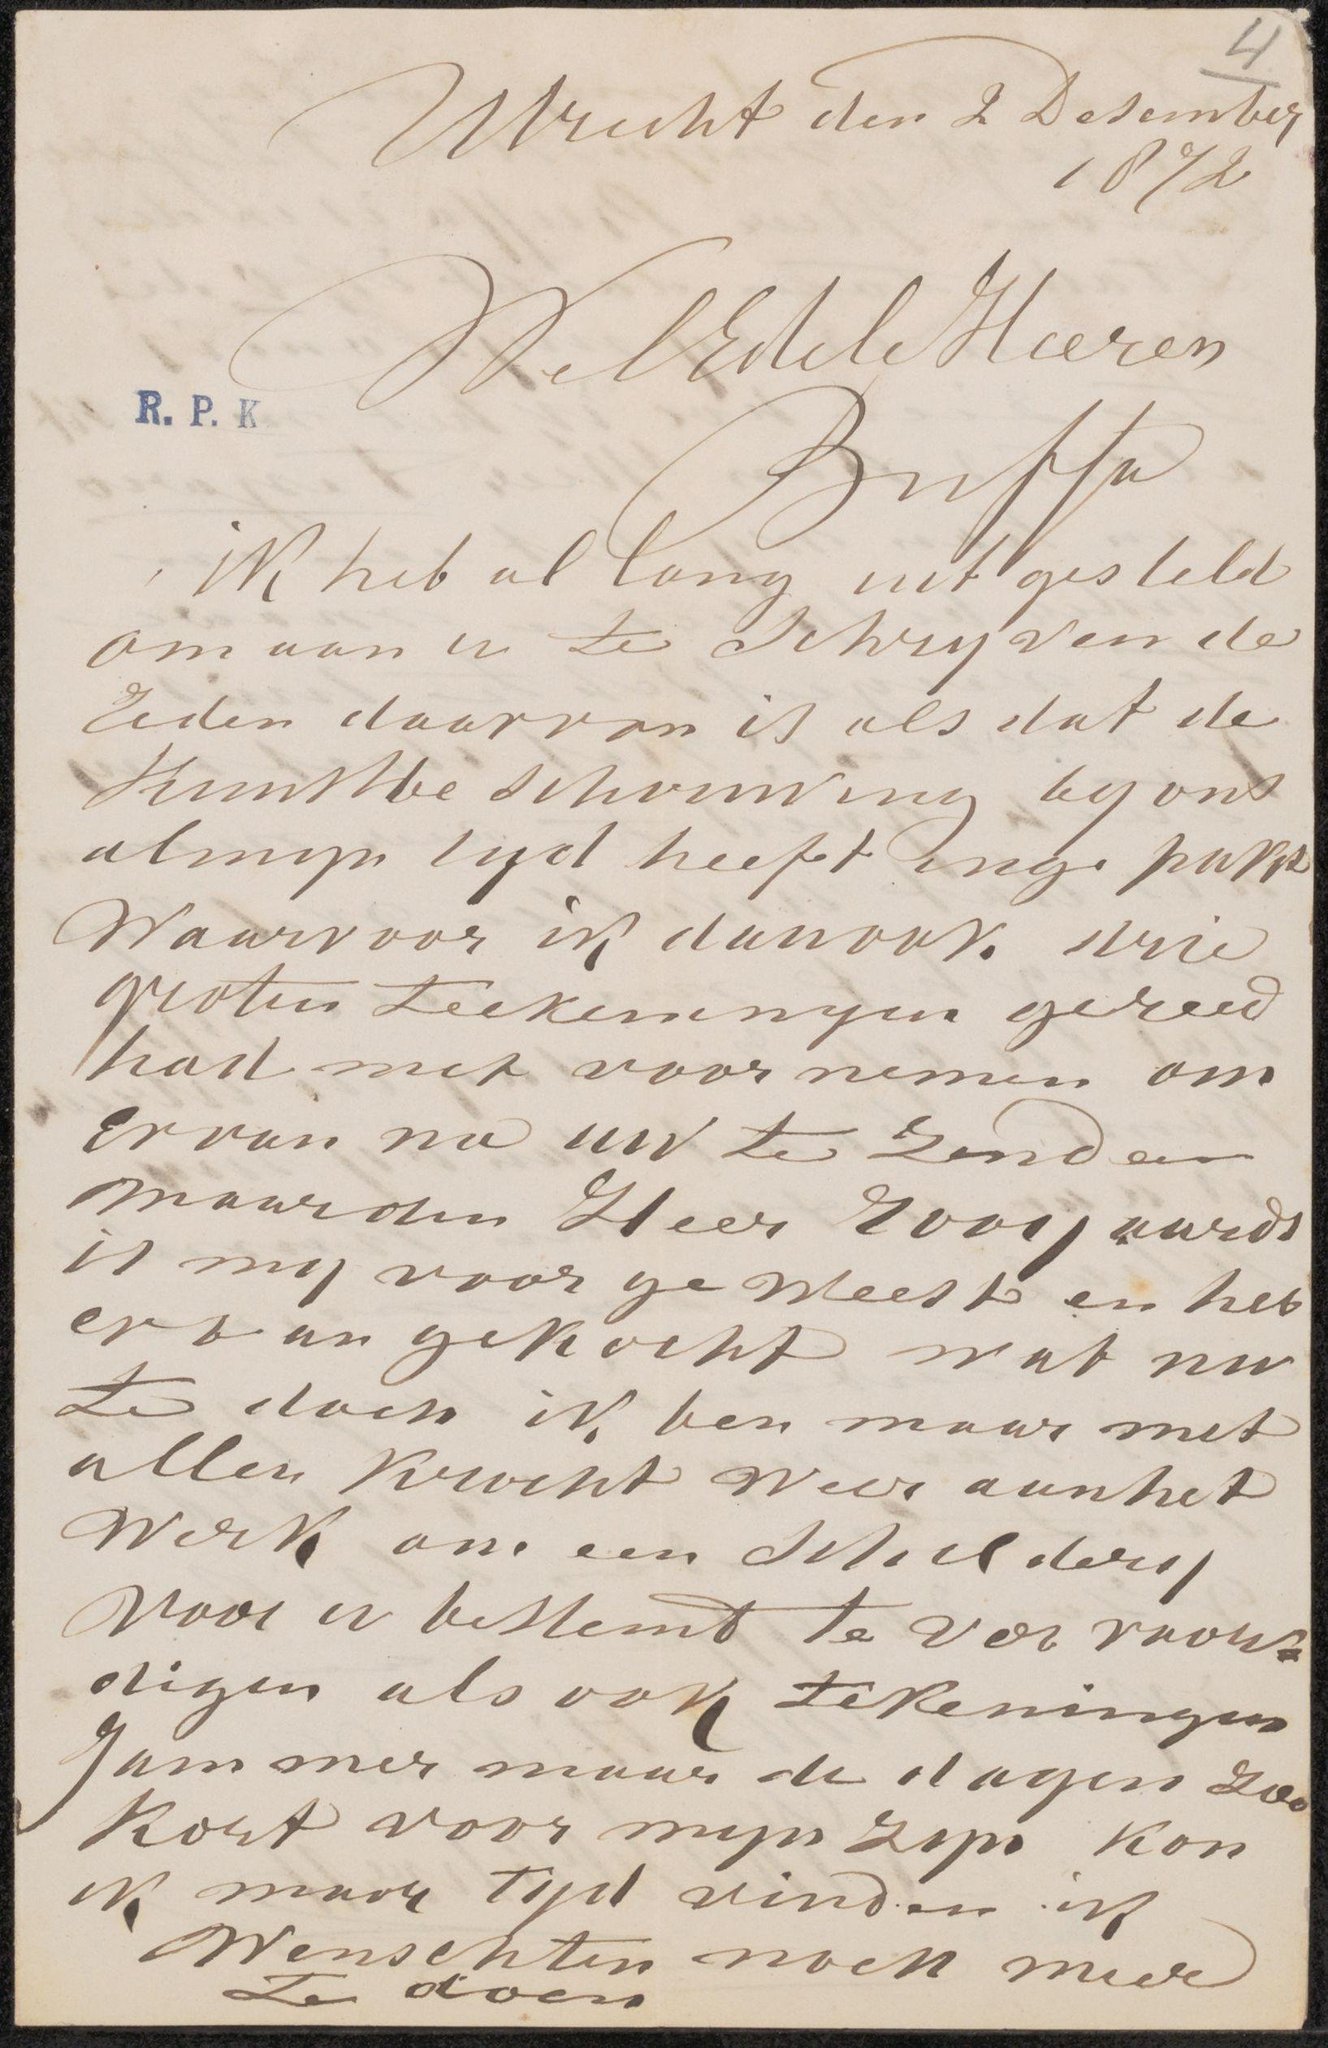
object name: letter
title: Brief aan Frans Buffa en Zonen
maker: dirk van lokhorst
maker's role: draughtsman, painter, print maker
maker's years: 1818-1893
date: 1872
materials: ink, paper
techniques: pen, writing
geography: utrecht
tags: amsterdam, willem jan roijaards van den ham, publisher, criticizing and discussing art, art criticism, art trade, art shop, drawing, painting (including book-illumination, miniature-painting), utrecht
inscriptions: collector's mark: Lugt 2233